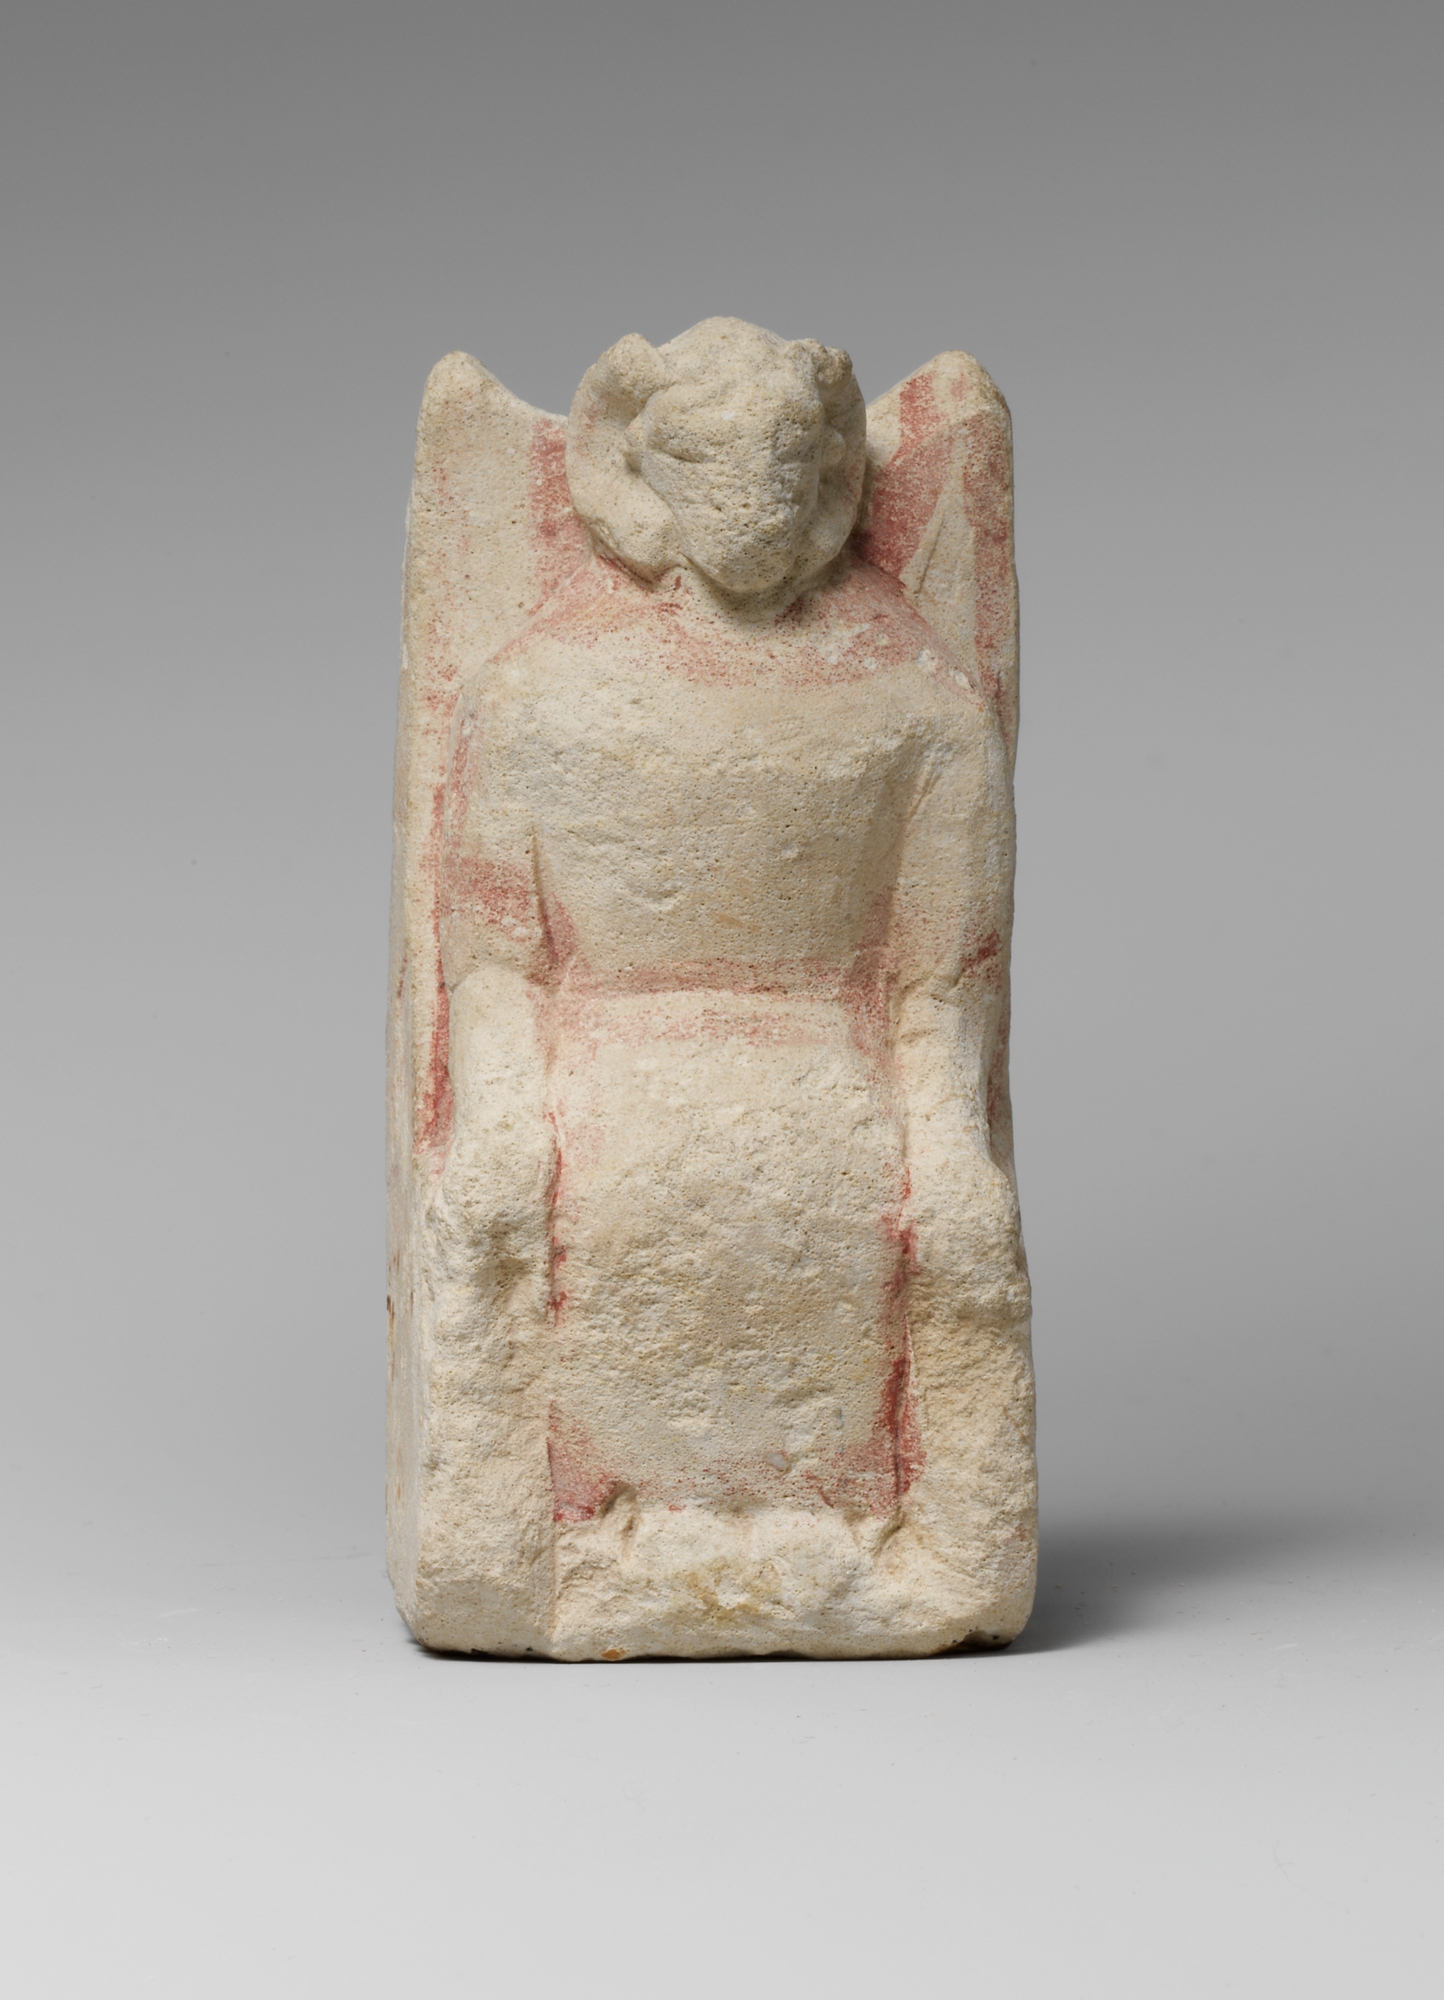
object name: statuette of zeus ammon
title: Limestone statuette of Zeus Ammon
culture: cypriot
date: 575-551 BCE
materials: limestone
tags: zeus